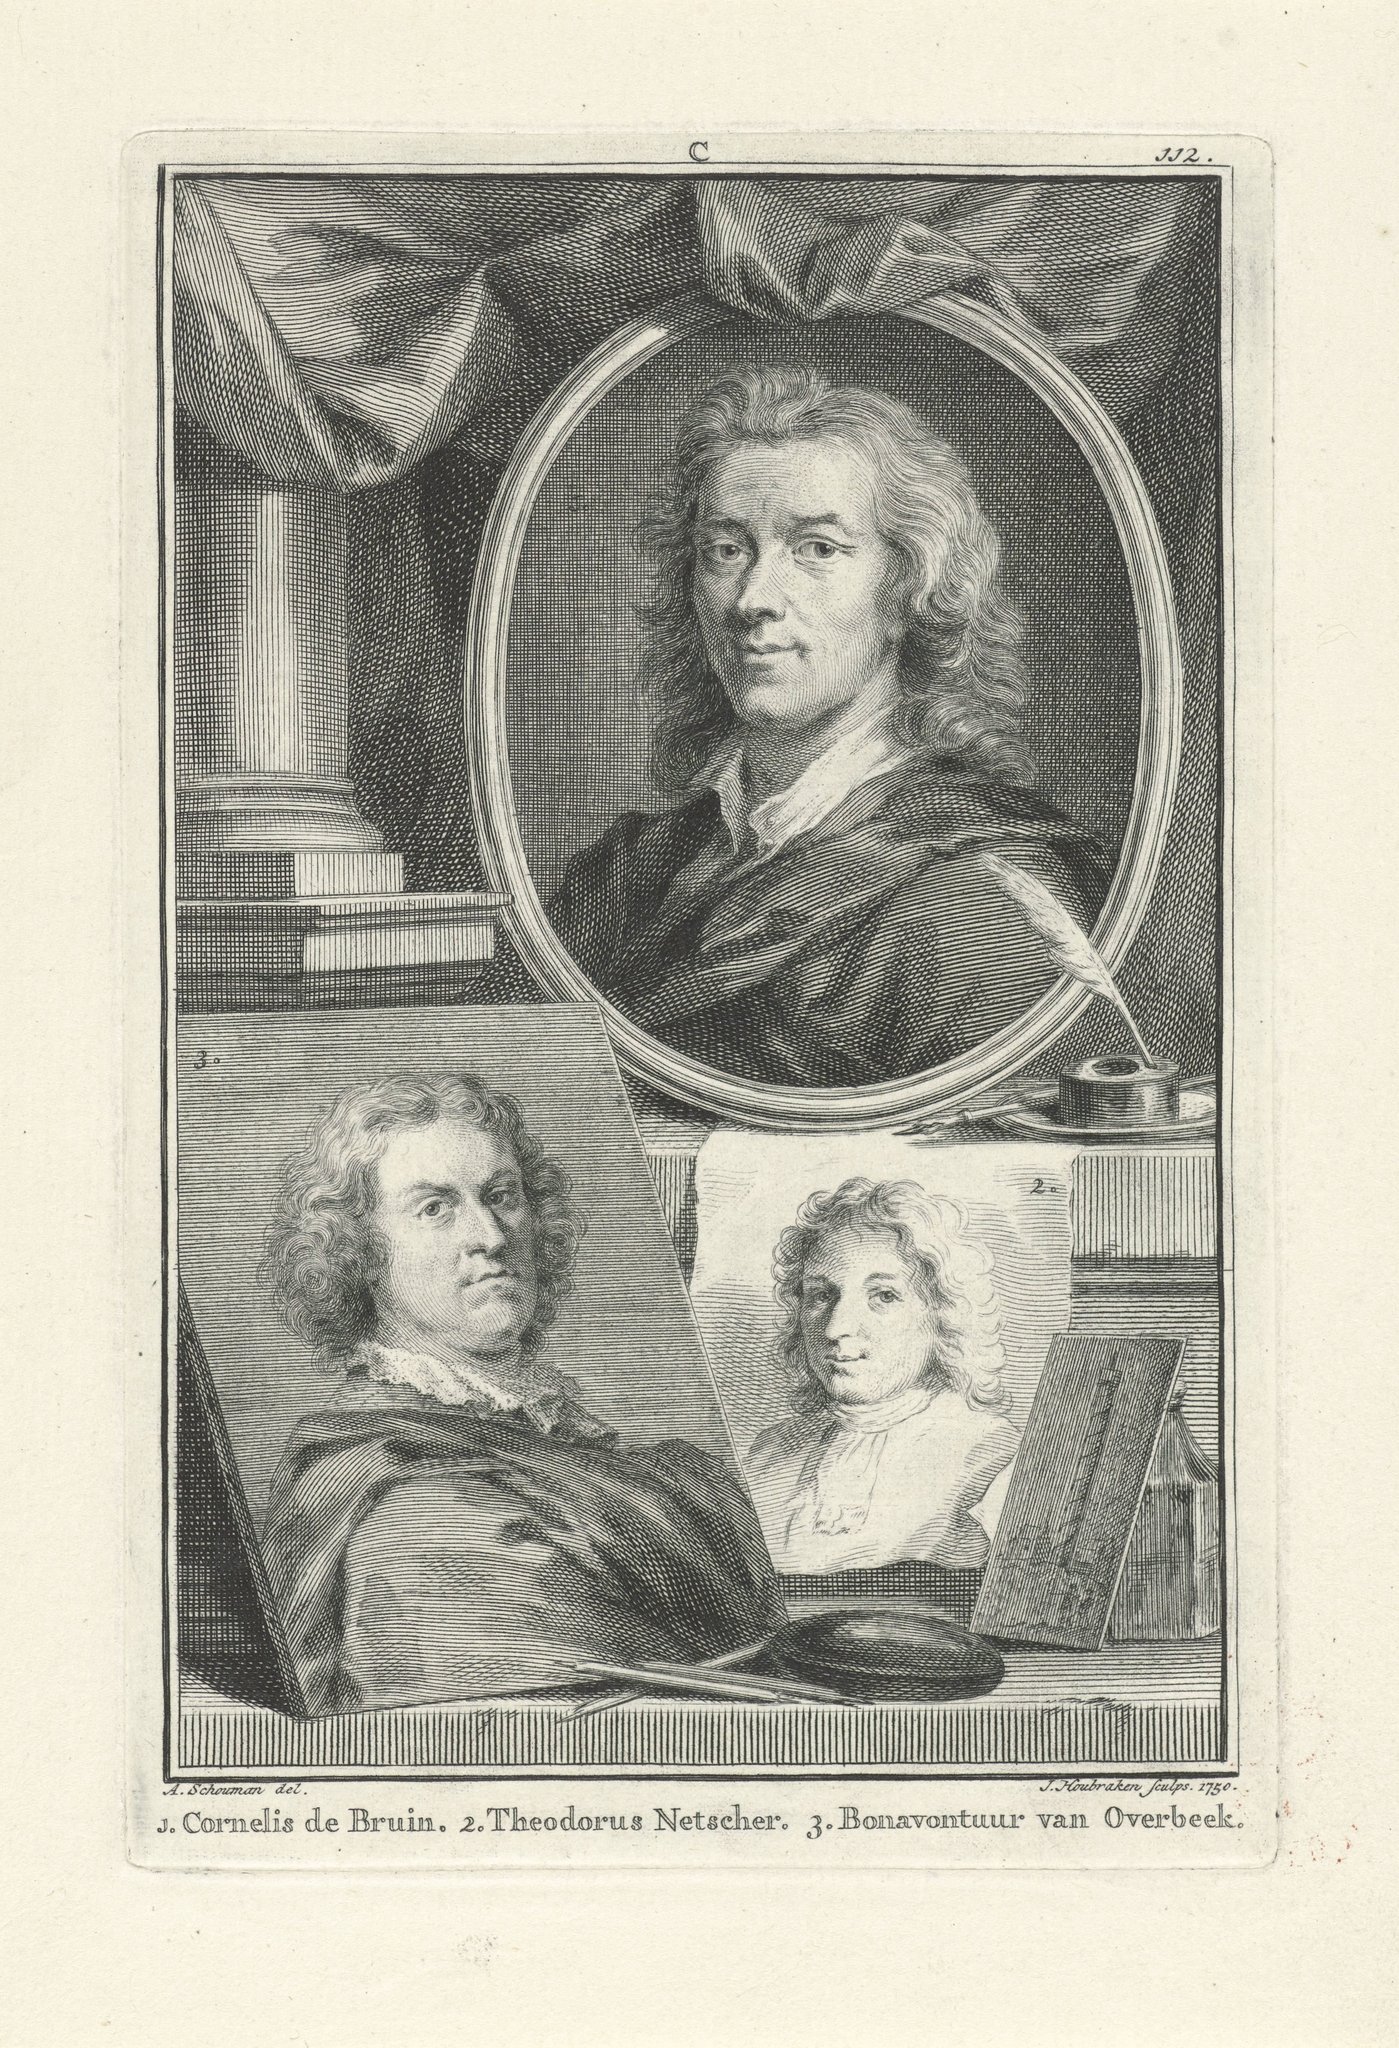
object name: book illustration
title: Portretten van Cornelis de Bruyn, Theodorus Netscher en Bonaventura van Overbeek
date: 1750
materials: paper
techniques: engraving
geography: amsterdam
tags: the hague, cornelis de bruyn, draughtsman, theodorus netscher, print maker, bonaventura van overbeek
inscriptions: collector's mark: Lugt 240, name: ‘JvGool’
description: Prent ook gebruikt in: Johan van Gool. De nieuwe Schouburg der Nederlantsche kunstschilders en schilderessen : waer in de levens- en kunstbedrijven er tans levende en reets overleedene schilders, die van Houbraken, noch eenig ander schrijver, zijn aengeteekend, verhaelt worden. 2 dl. Den Haag: 1750-1751.